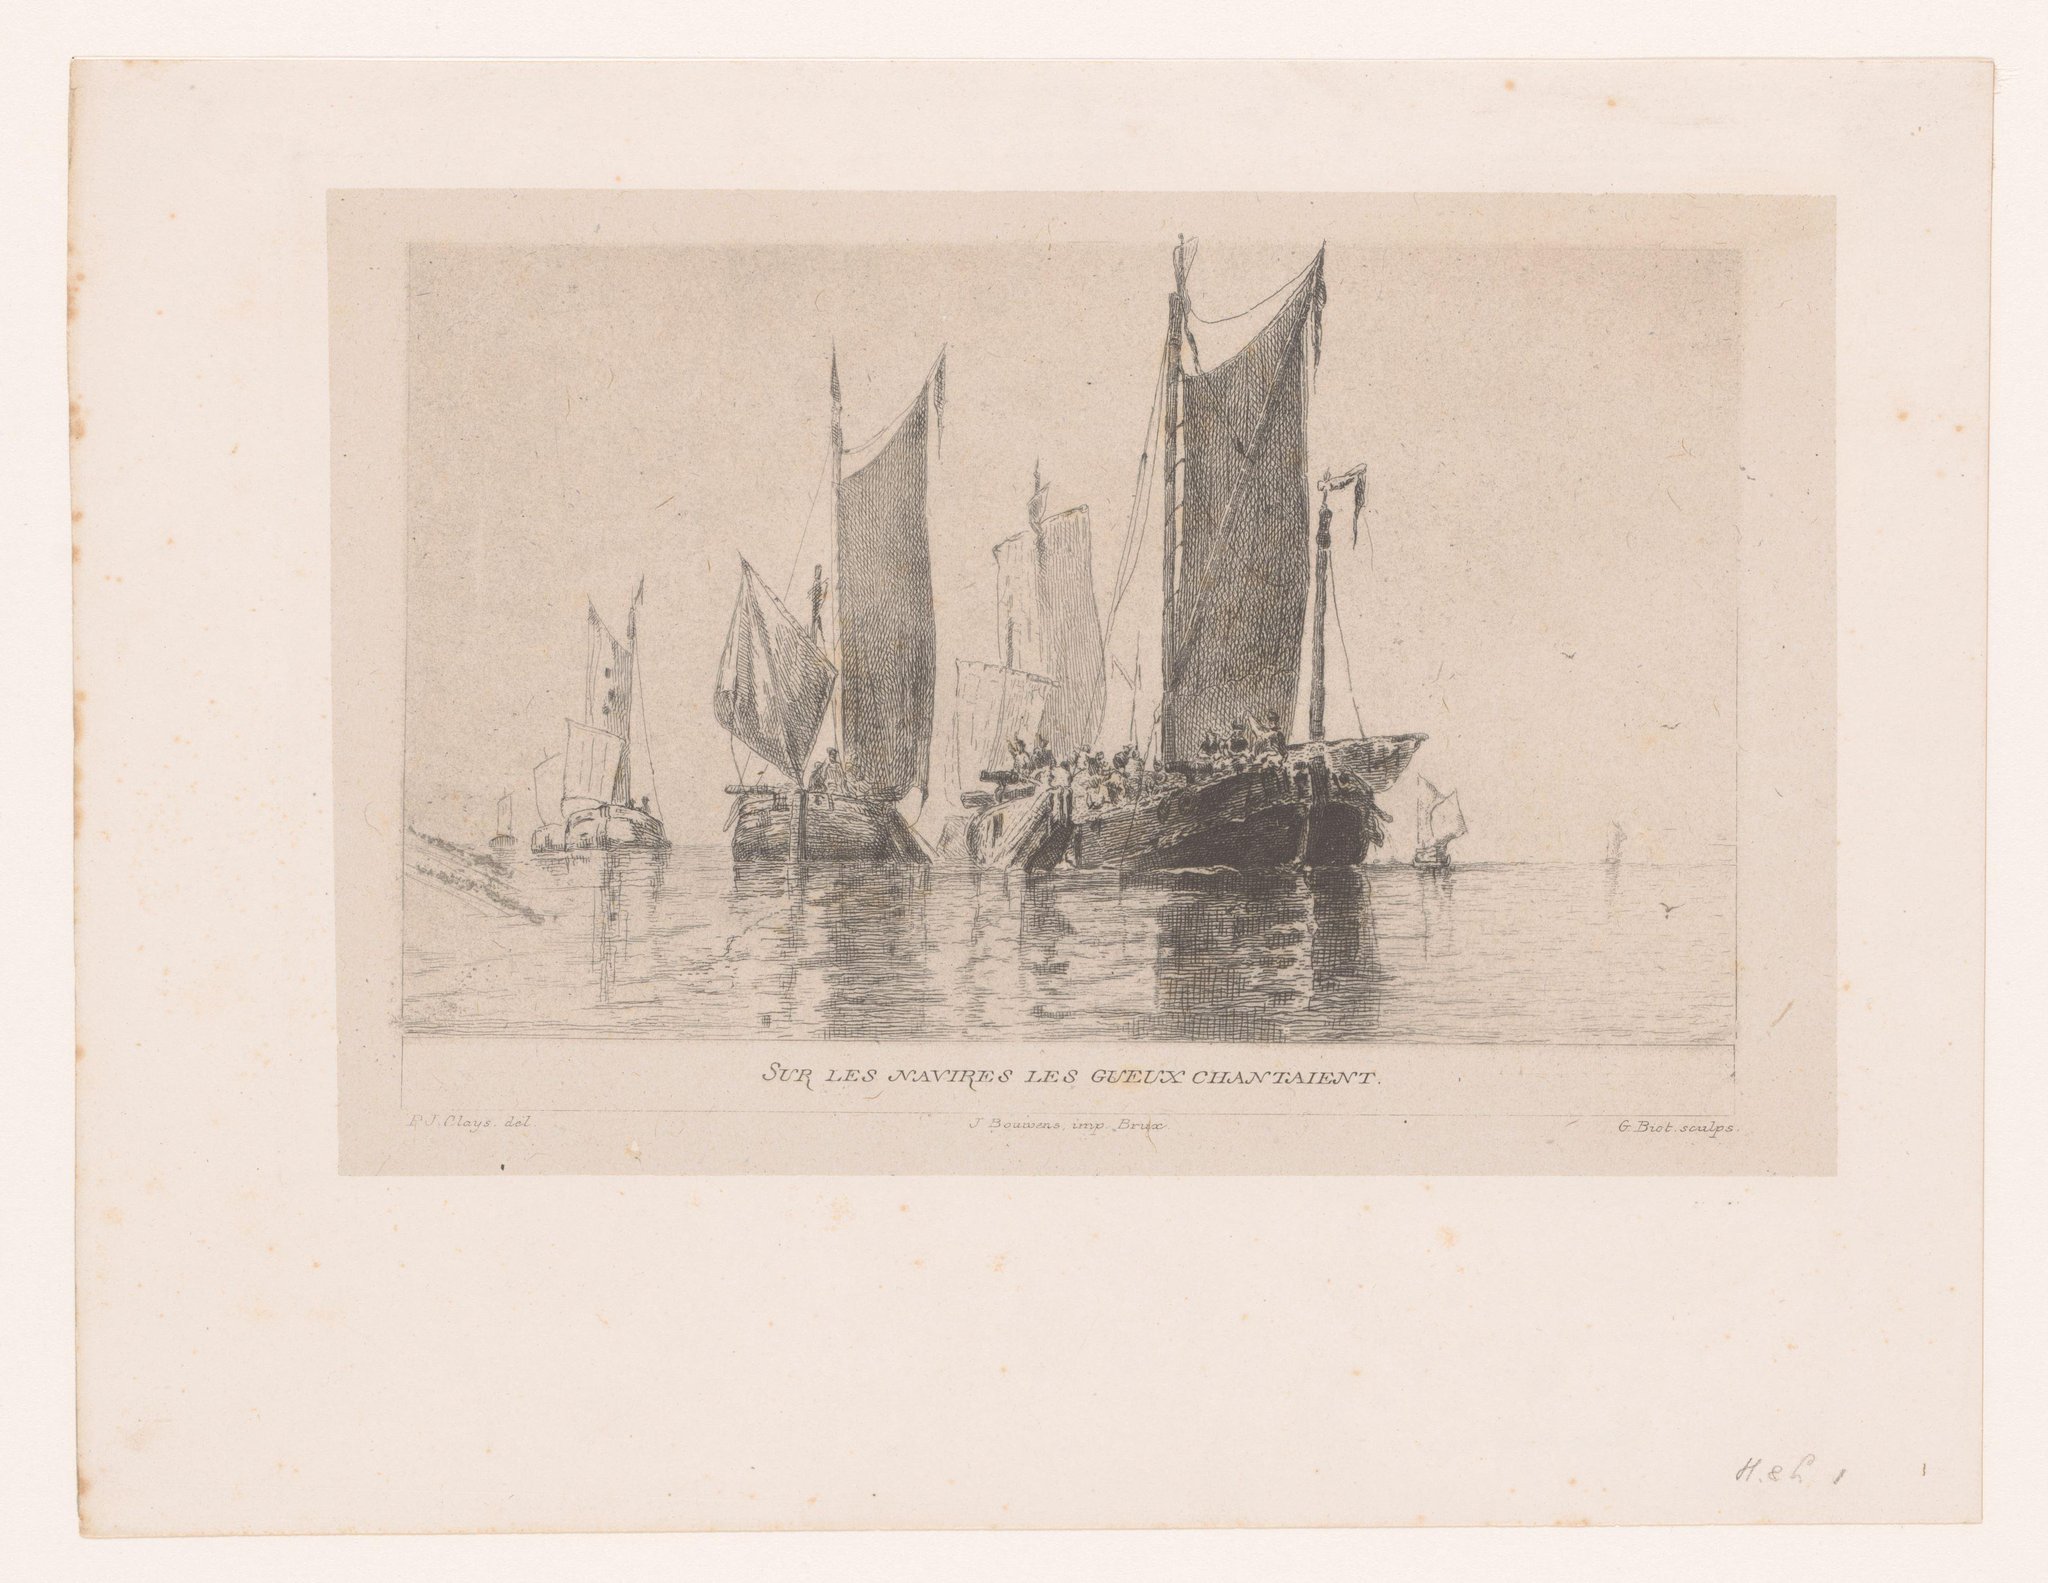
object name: book illustration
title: Zeilschepen van de Geuzen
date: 1843-1905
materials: paper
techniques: etching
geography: brussels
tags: sailing-ship, sailing-boat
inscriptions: collector's mark: Lugt 2228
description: Prent uit: Coster, Charles de. Le légende et les aventures héroiques, joyeuses et glorieuses d'Ulenspiegel et de Lamme Goedzak au pays de Flandres et ailleurs. Parijs: s.n., [1867].